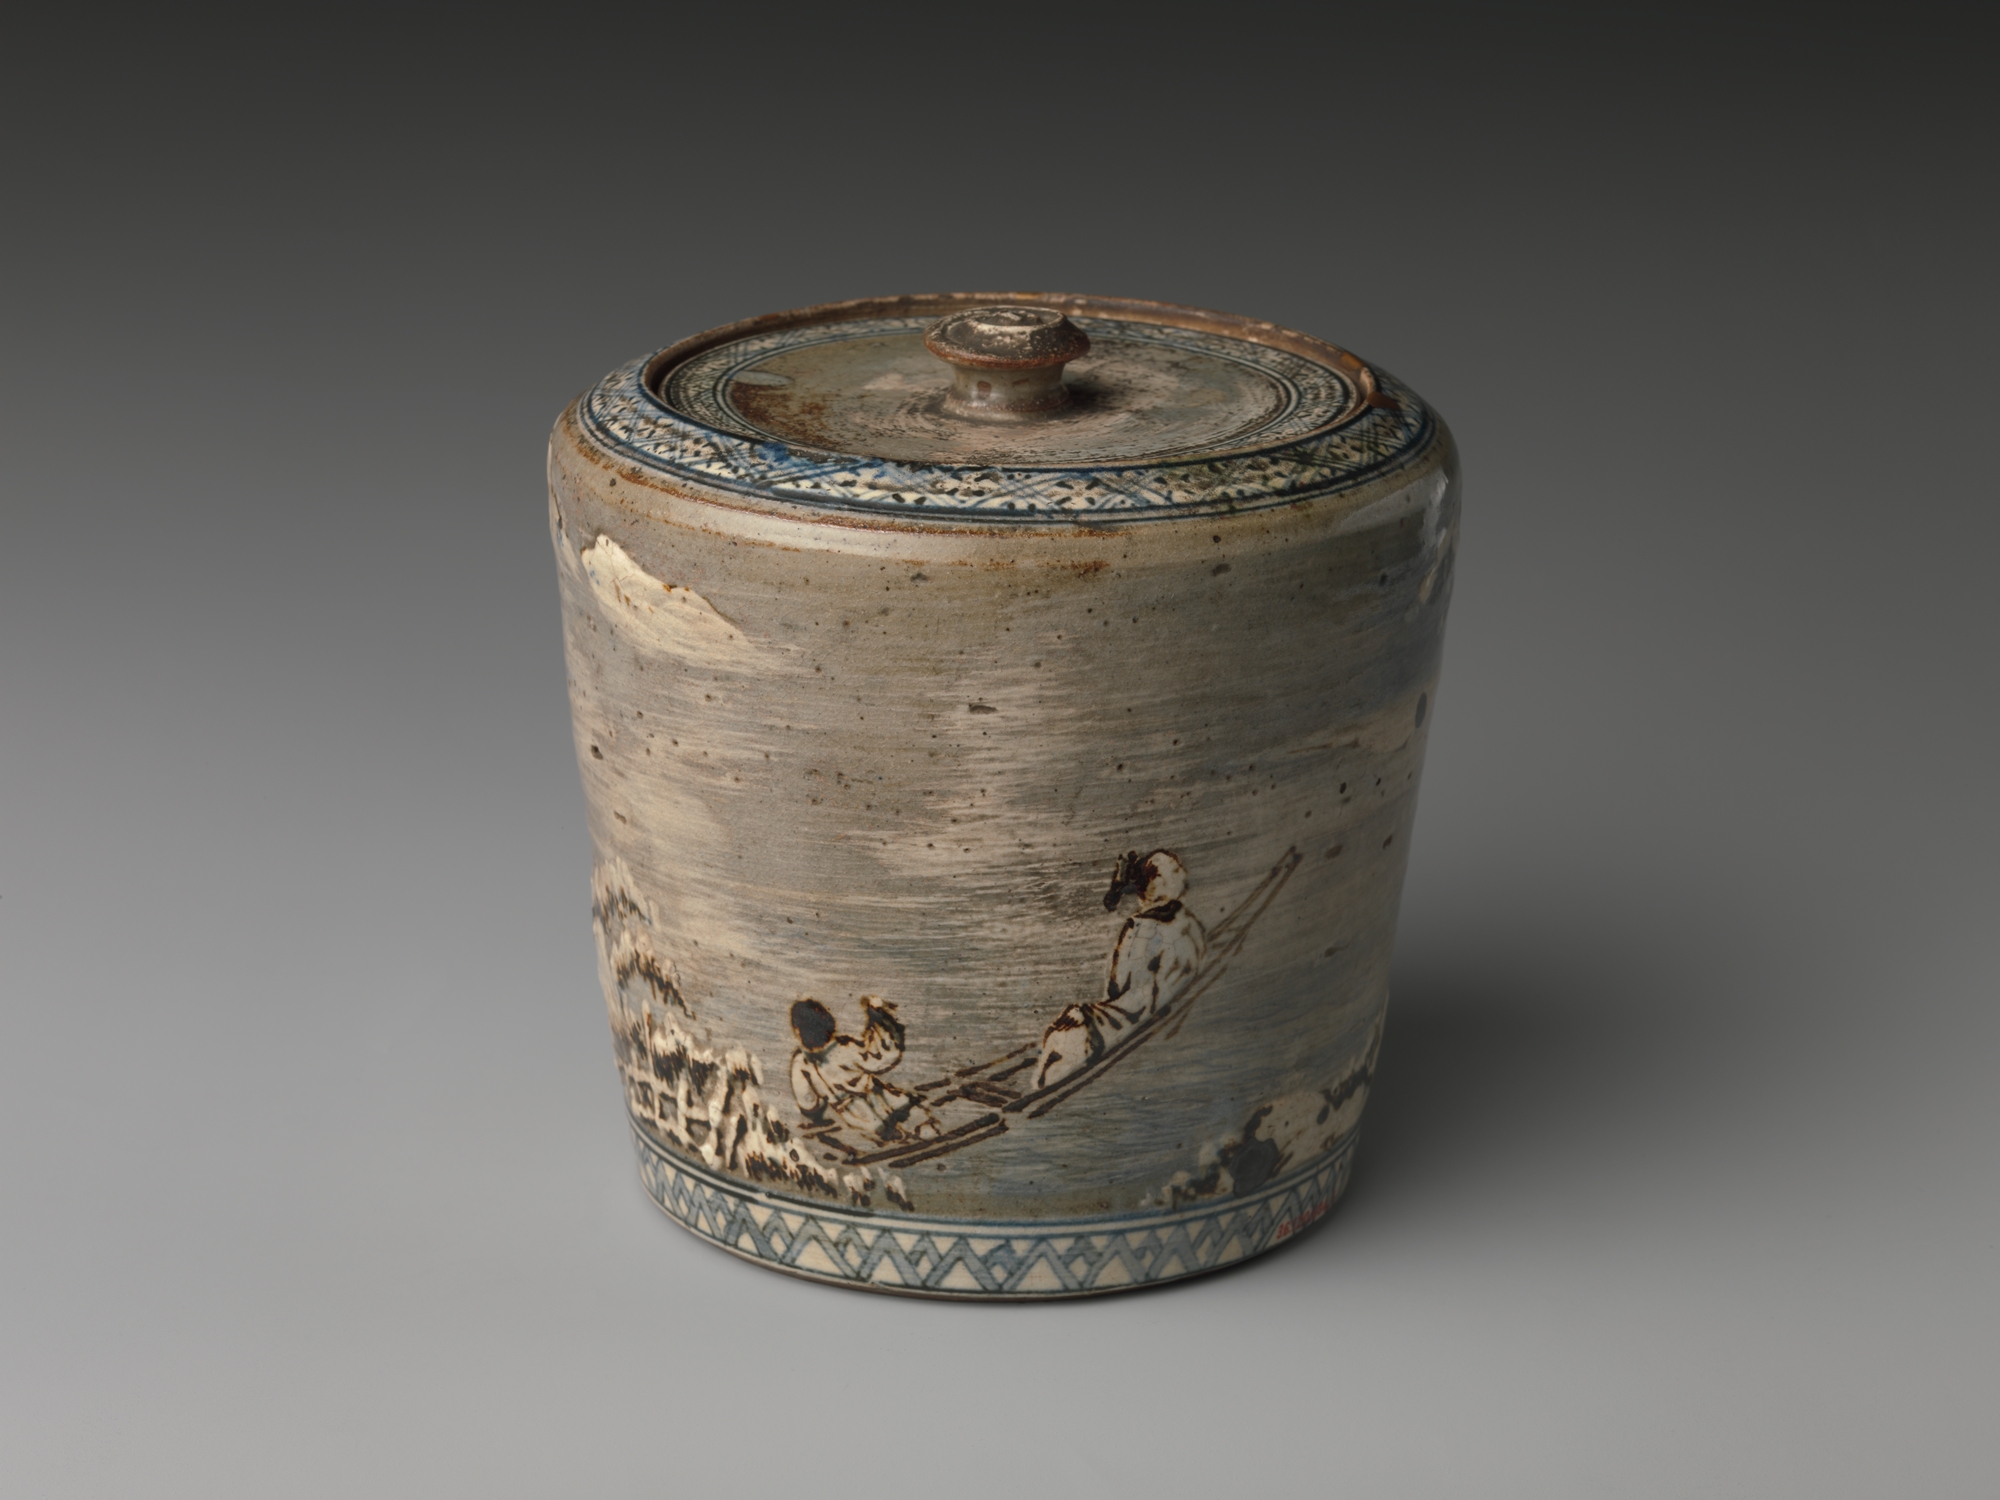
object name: water jar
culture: japanese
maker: ogata kenzan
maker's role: artist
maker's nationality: japanese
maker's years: 1663-1743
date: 1705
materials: clay, glaze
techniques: relief, underglaze